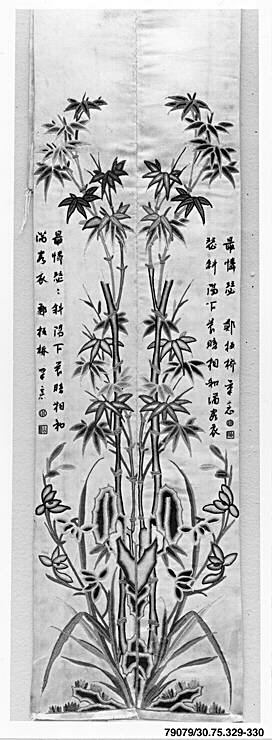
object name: sleeve band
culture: chinese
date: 1801-1900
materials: silk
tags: trees